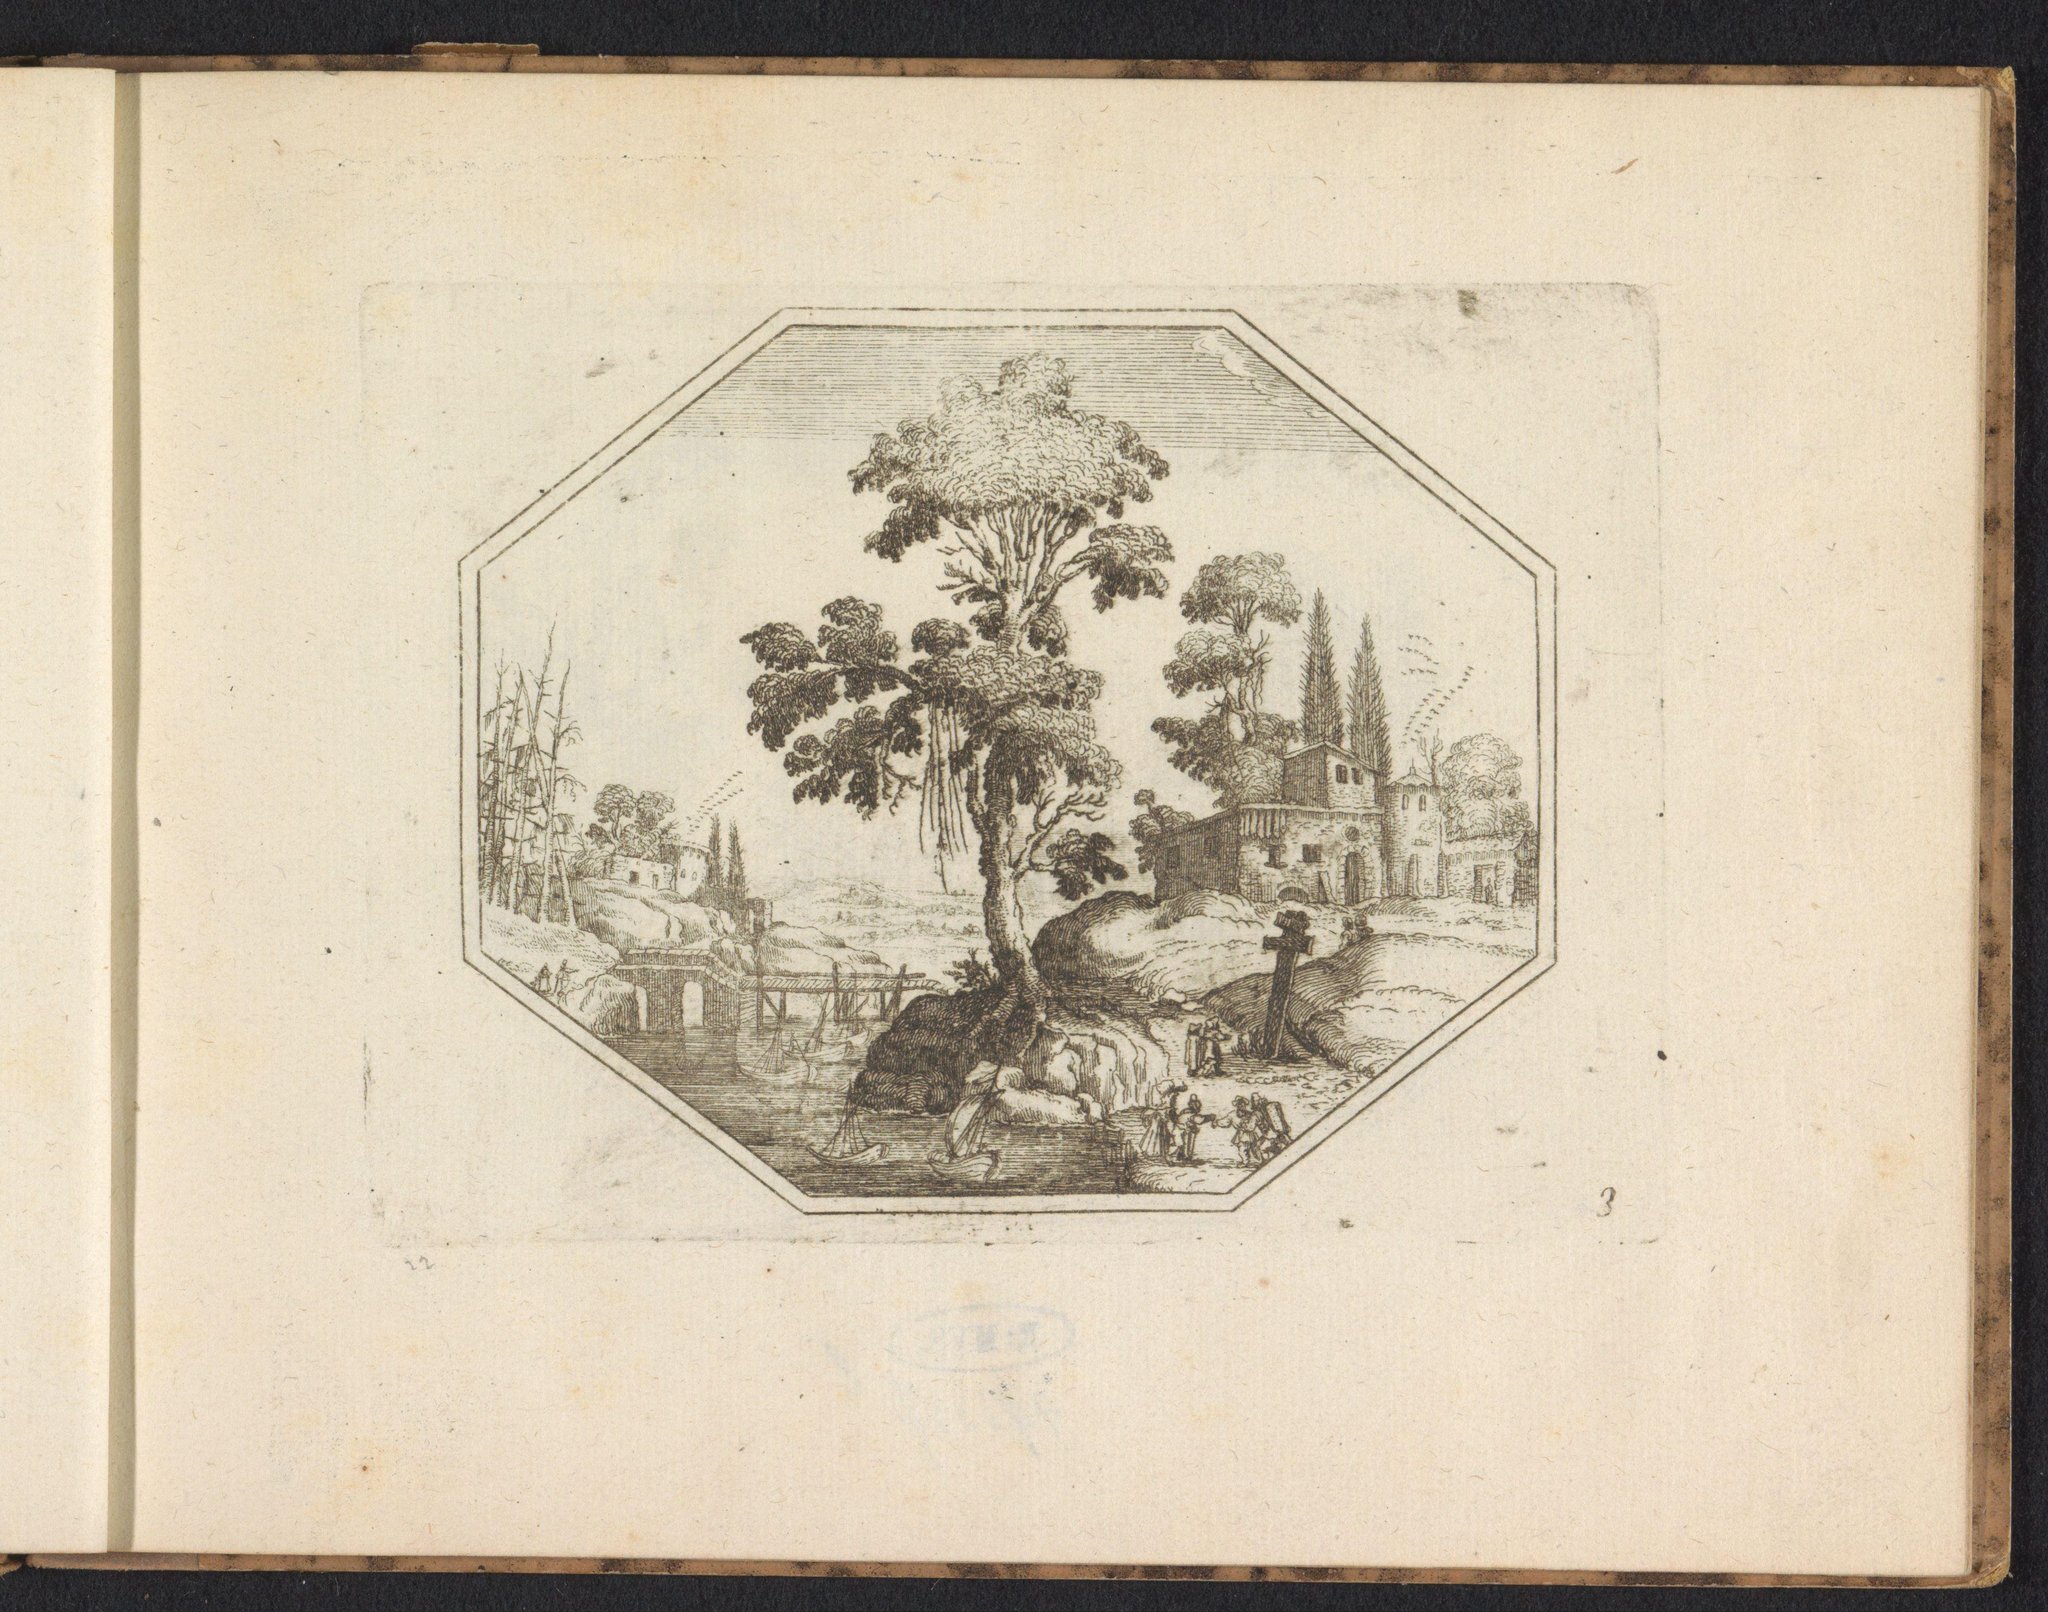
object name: album leaf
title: Achthoekige landschappen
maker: Anonymous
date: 1626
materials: paper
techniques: etching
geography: northern netherlands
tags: landscapes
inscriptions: collector's mark: Lugt 2228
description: Landschap met een boom naast een houten brug. Rechts een houten bewegwijzeringspaal en verschillende reizigers. De prent maakt deel uit van een album.